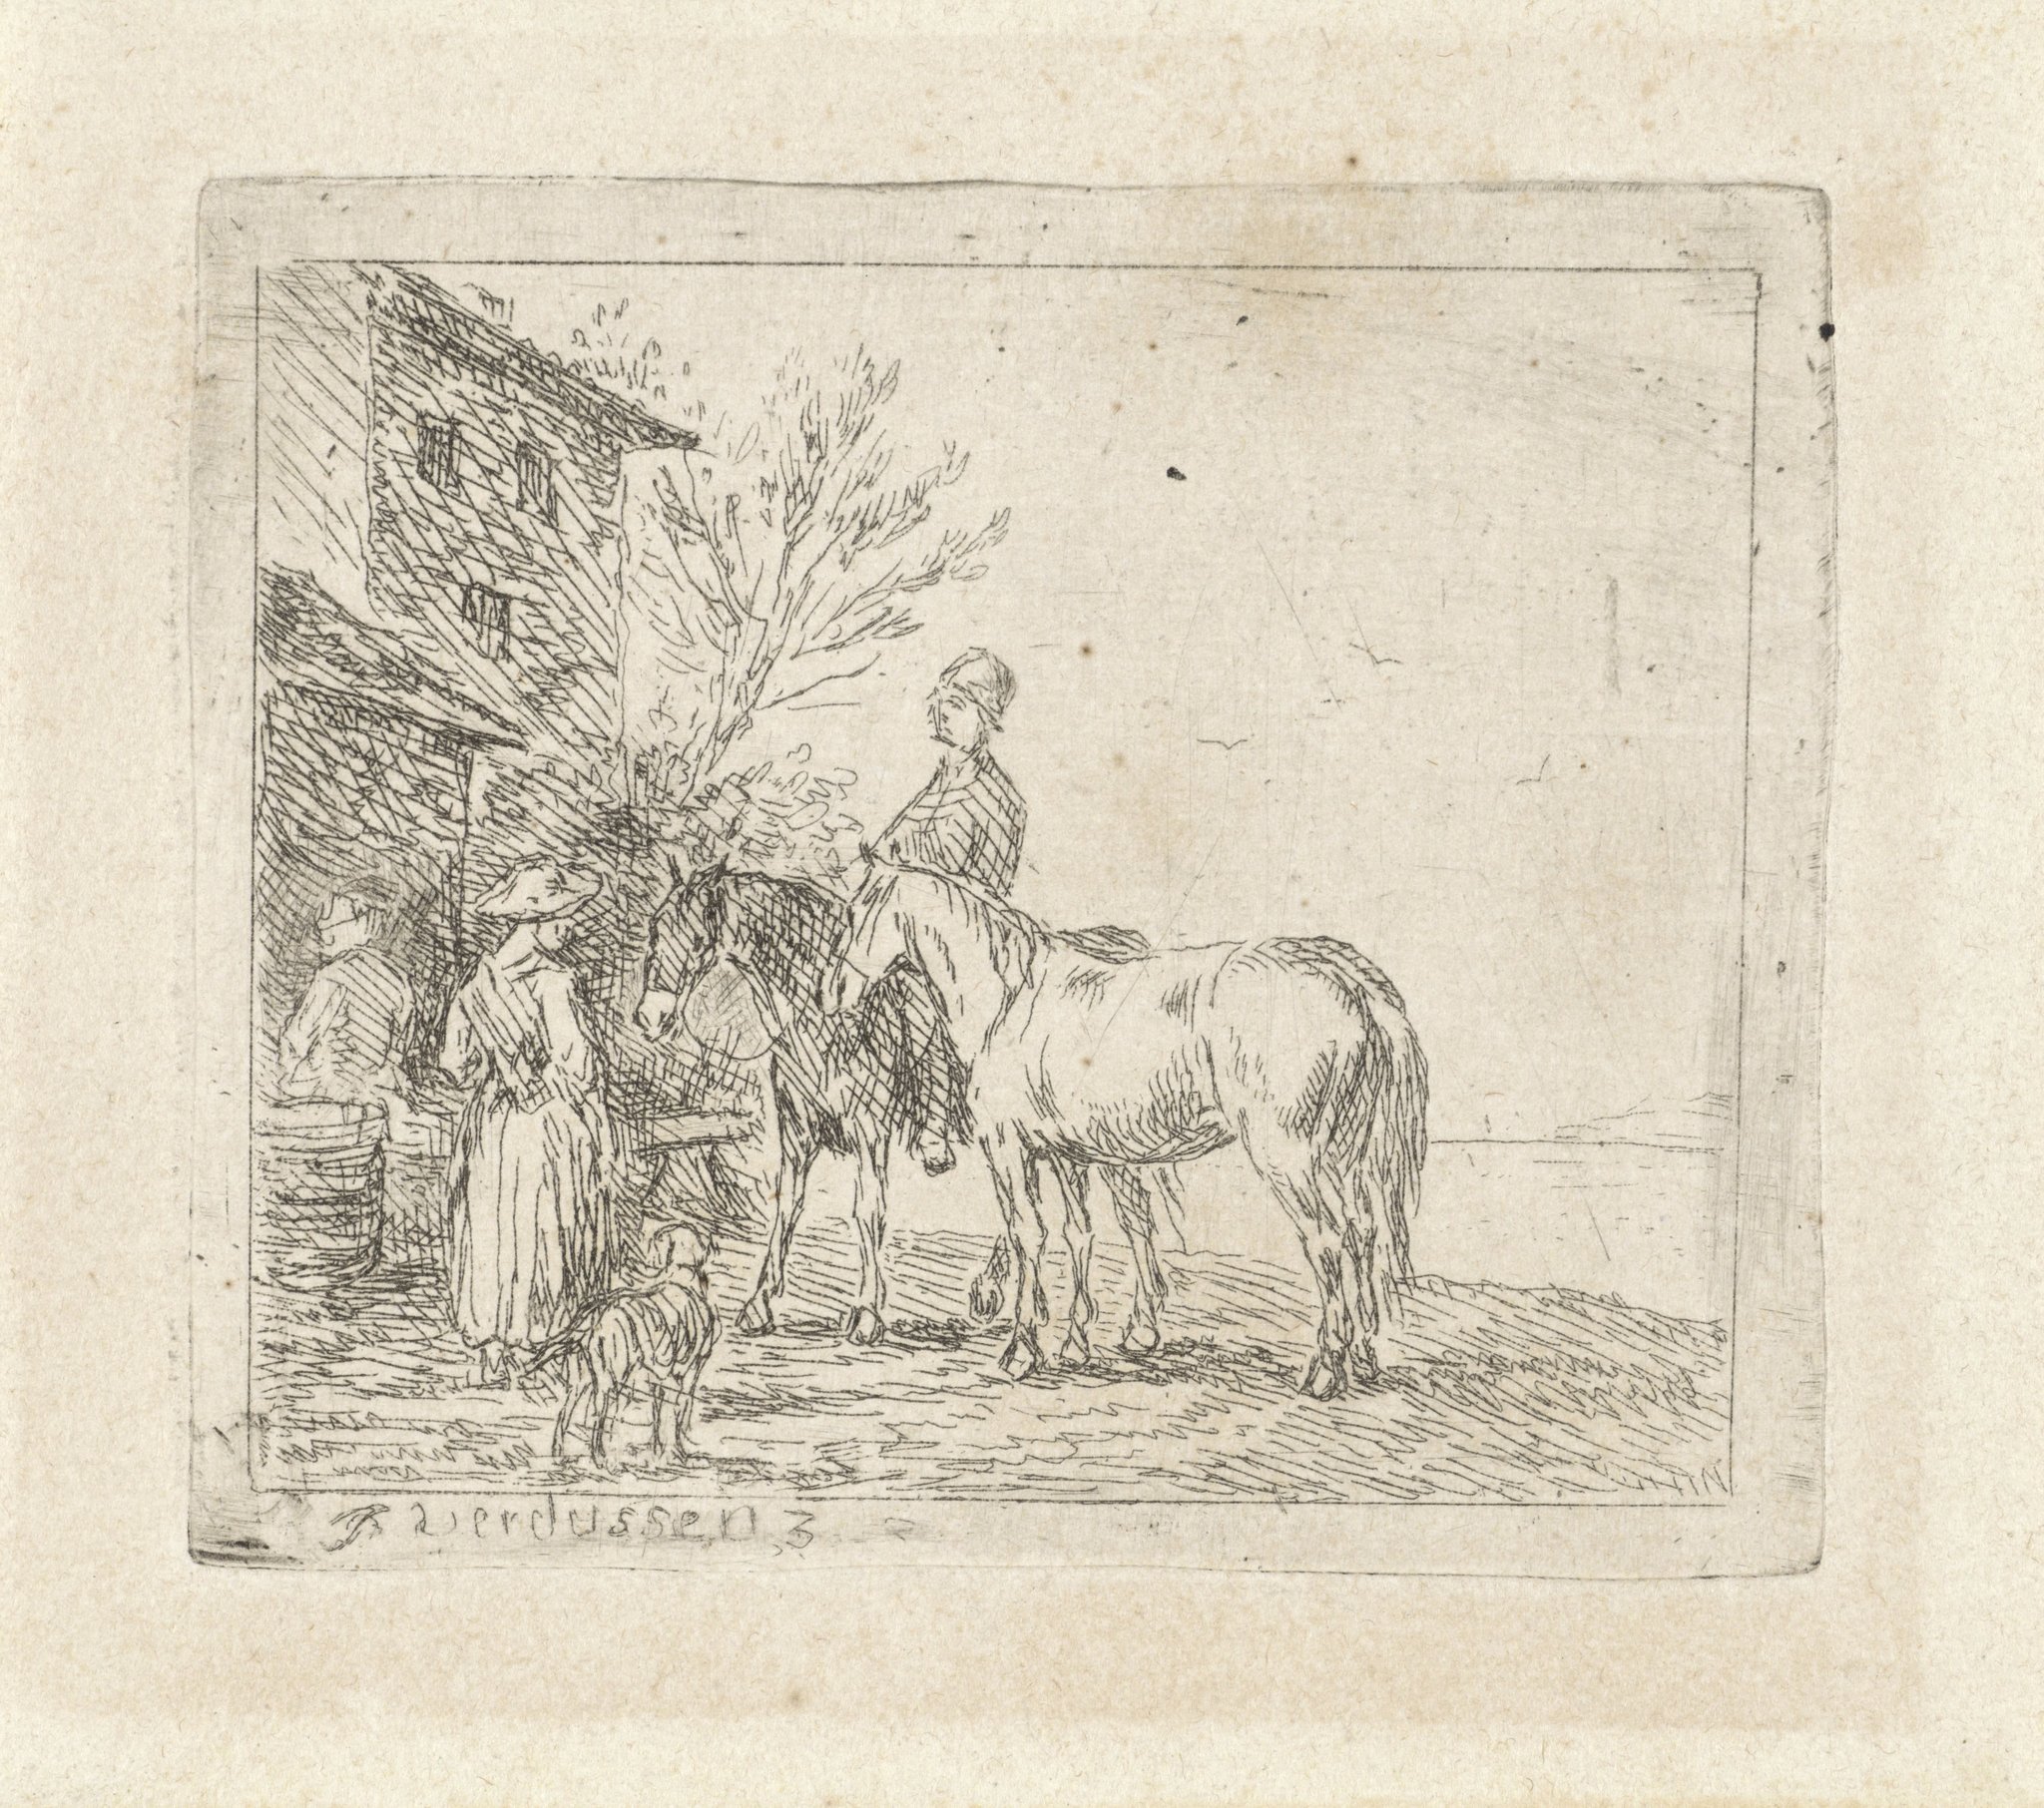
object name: print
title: Ruiter voor een huis, met figuren en een hond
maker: jan peeter verdussen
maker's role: print maker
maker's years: 1700-1763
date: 1710-1763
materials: paper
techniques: etching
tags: riding a horse, ass, or mule; rider, horseman, horse, dog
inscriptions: collector's mark: Lugt 2228, collector's mark: Lugt 2760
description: Een ruiter met naast hem een paard staat voor een huis, met figuren en een hond.